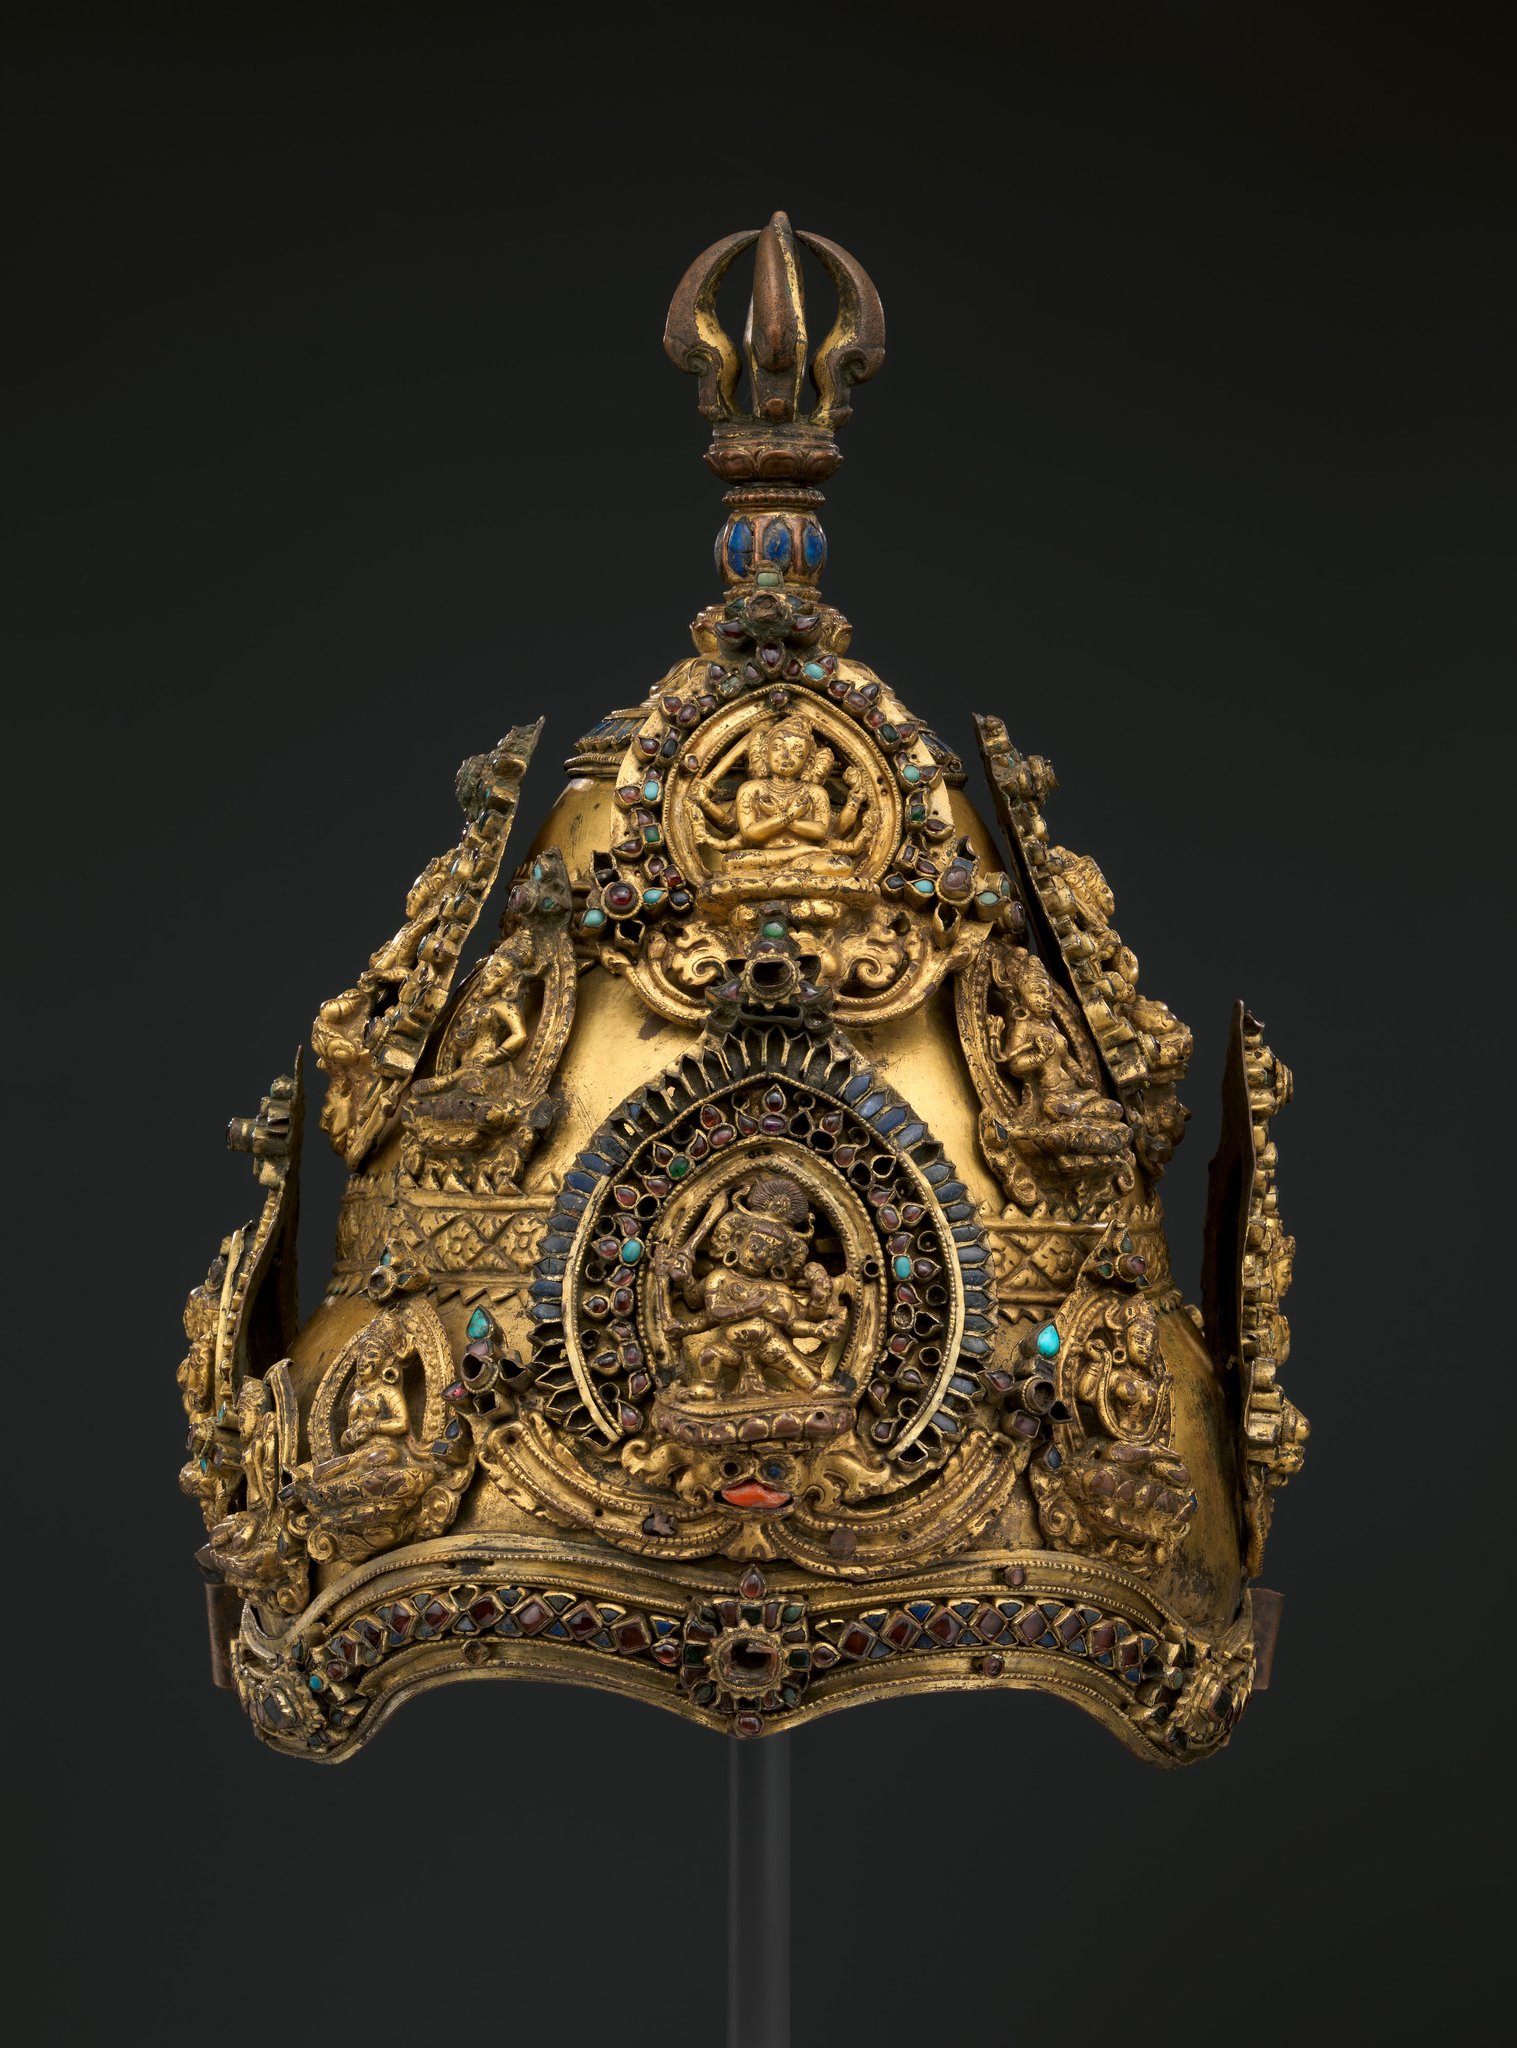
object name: crown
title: Vajracharya Priest’s Crown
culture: nepali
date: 1201-1333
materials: copper alloy, gilt, lapis lazuli, stone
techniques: inlay